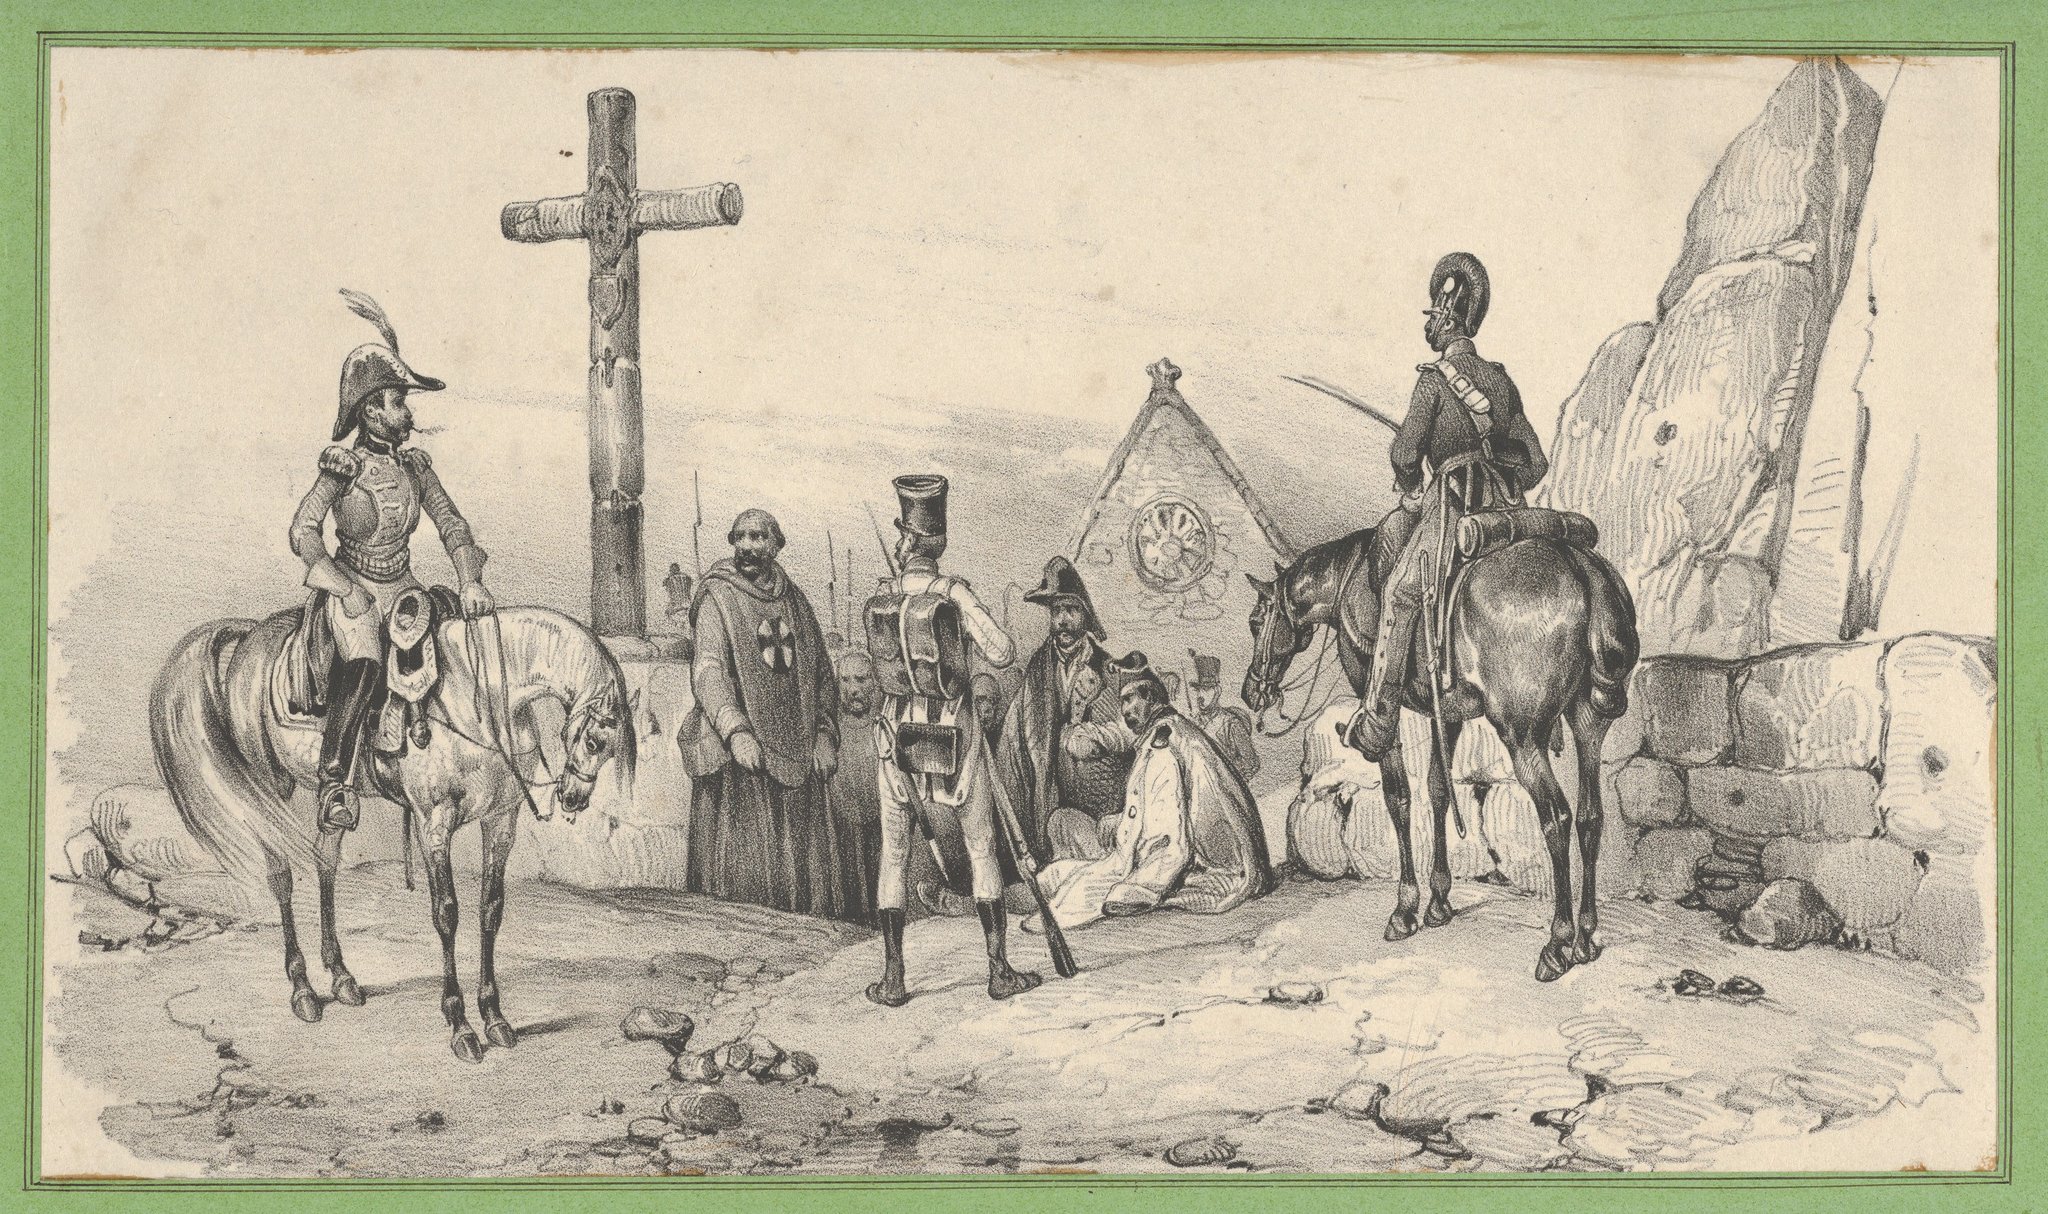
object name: print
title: Soldiers gathered in front of a church with priests and a crucifix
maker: victor adam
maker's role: artist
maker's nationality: french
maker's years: 1801-1866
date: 1834-1866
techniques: lithograph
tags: churches,soldiers,horses,cross,crucifixion